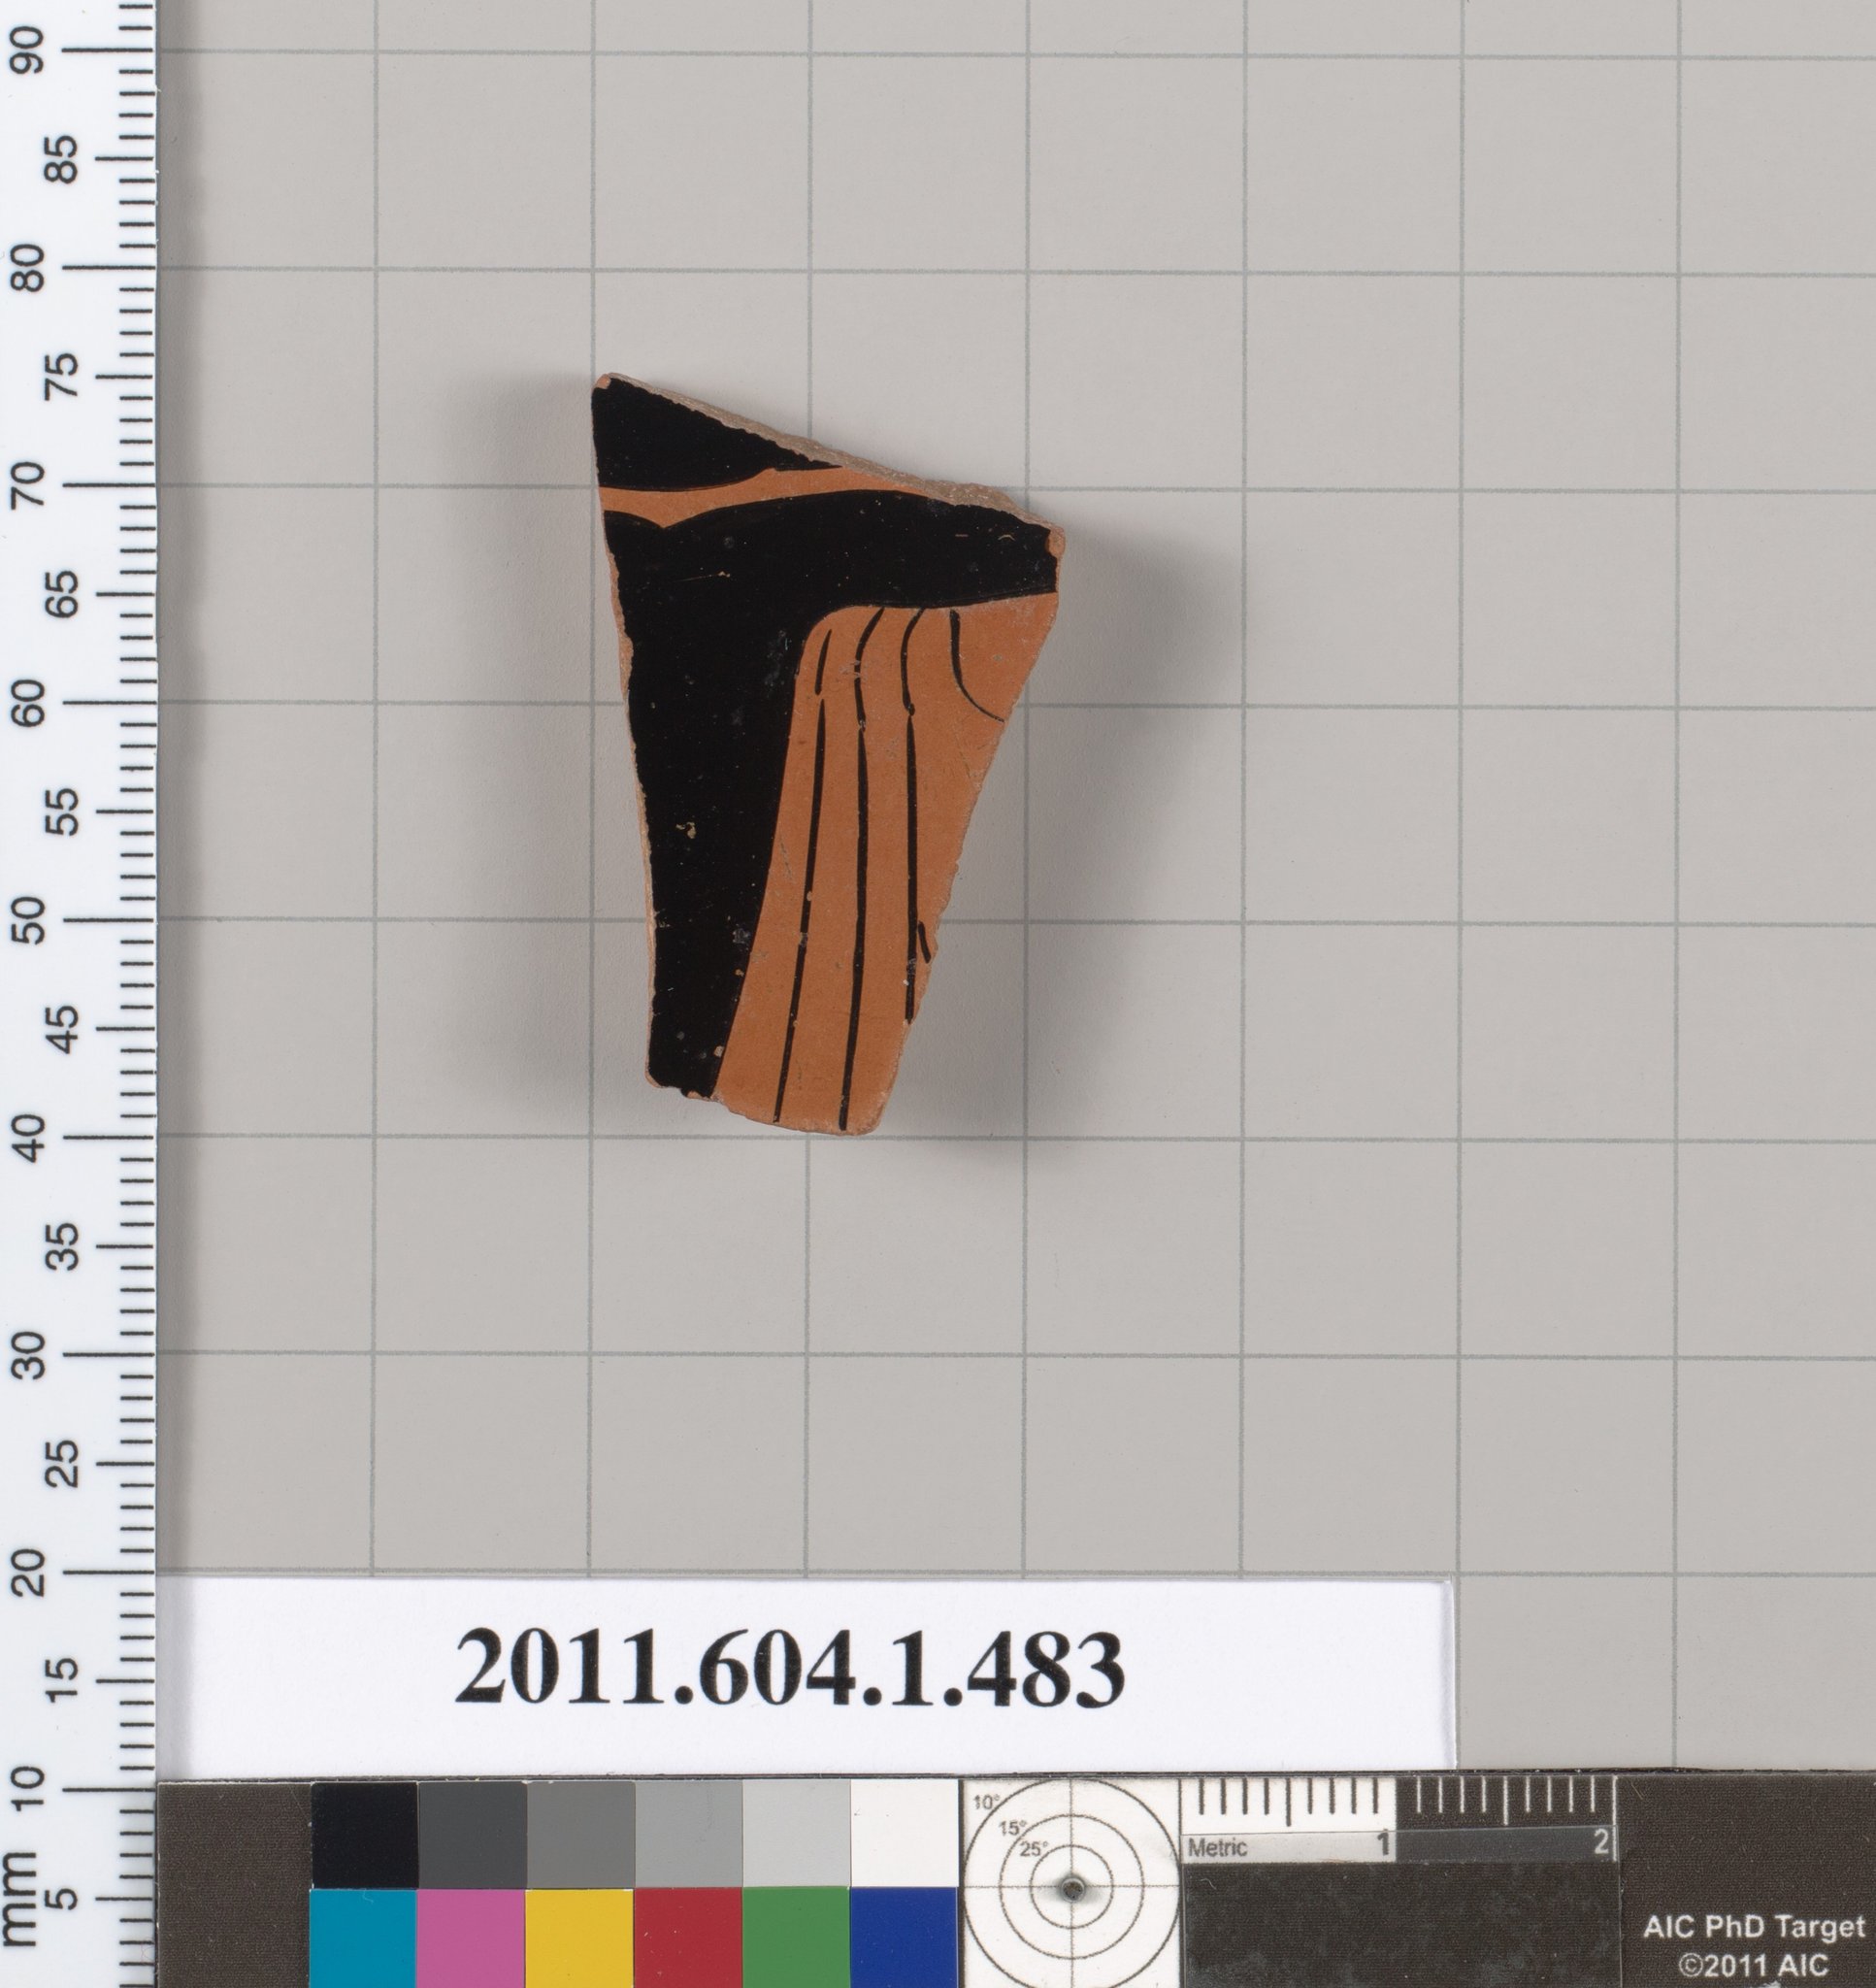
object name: kylix fragment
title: Terracotta fragment of a kylix (drinking cup)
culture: greek, attic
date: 490-480 BCE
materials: terracotta